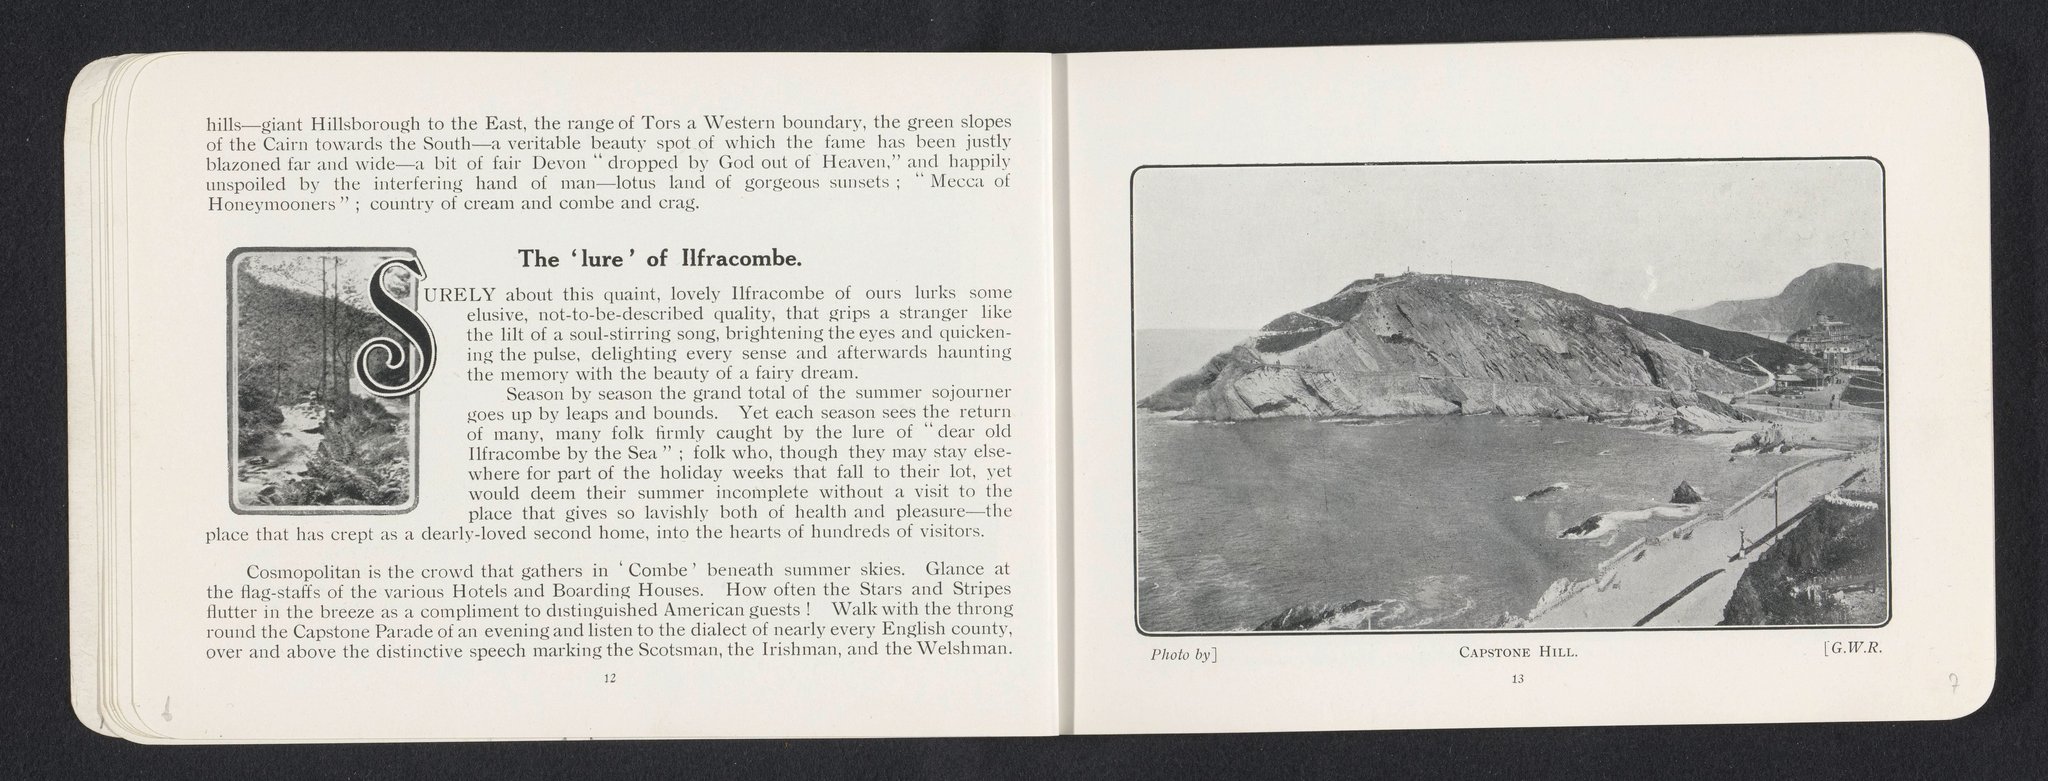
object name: page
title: Beek nabij Ilfracombe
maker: Anonymous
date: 1900-1920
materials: paper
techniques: autotype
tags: brook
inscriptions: inscription: ‘hills (...) and the Welshman.’